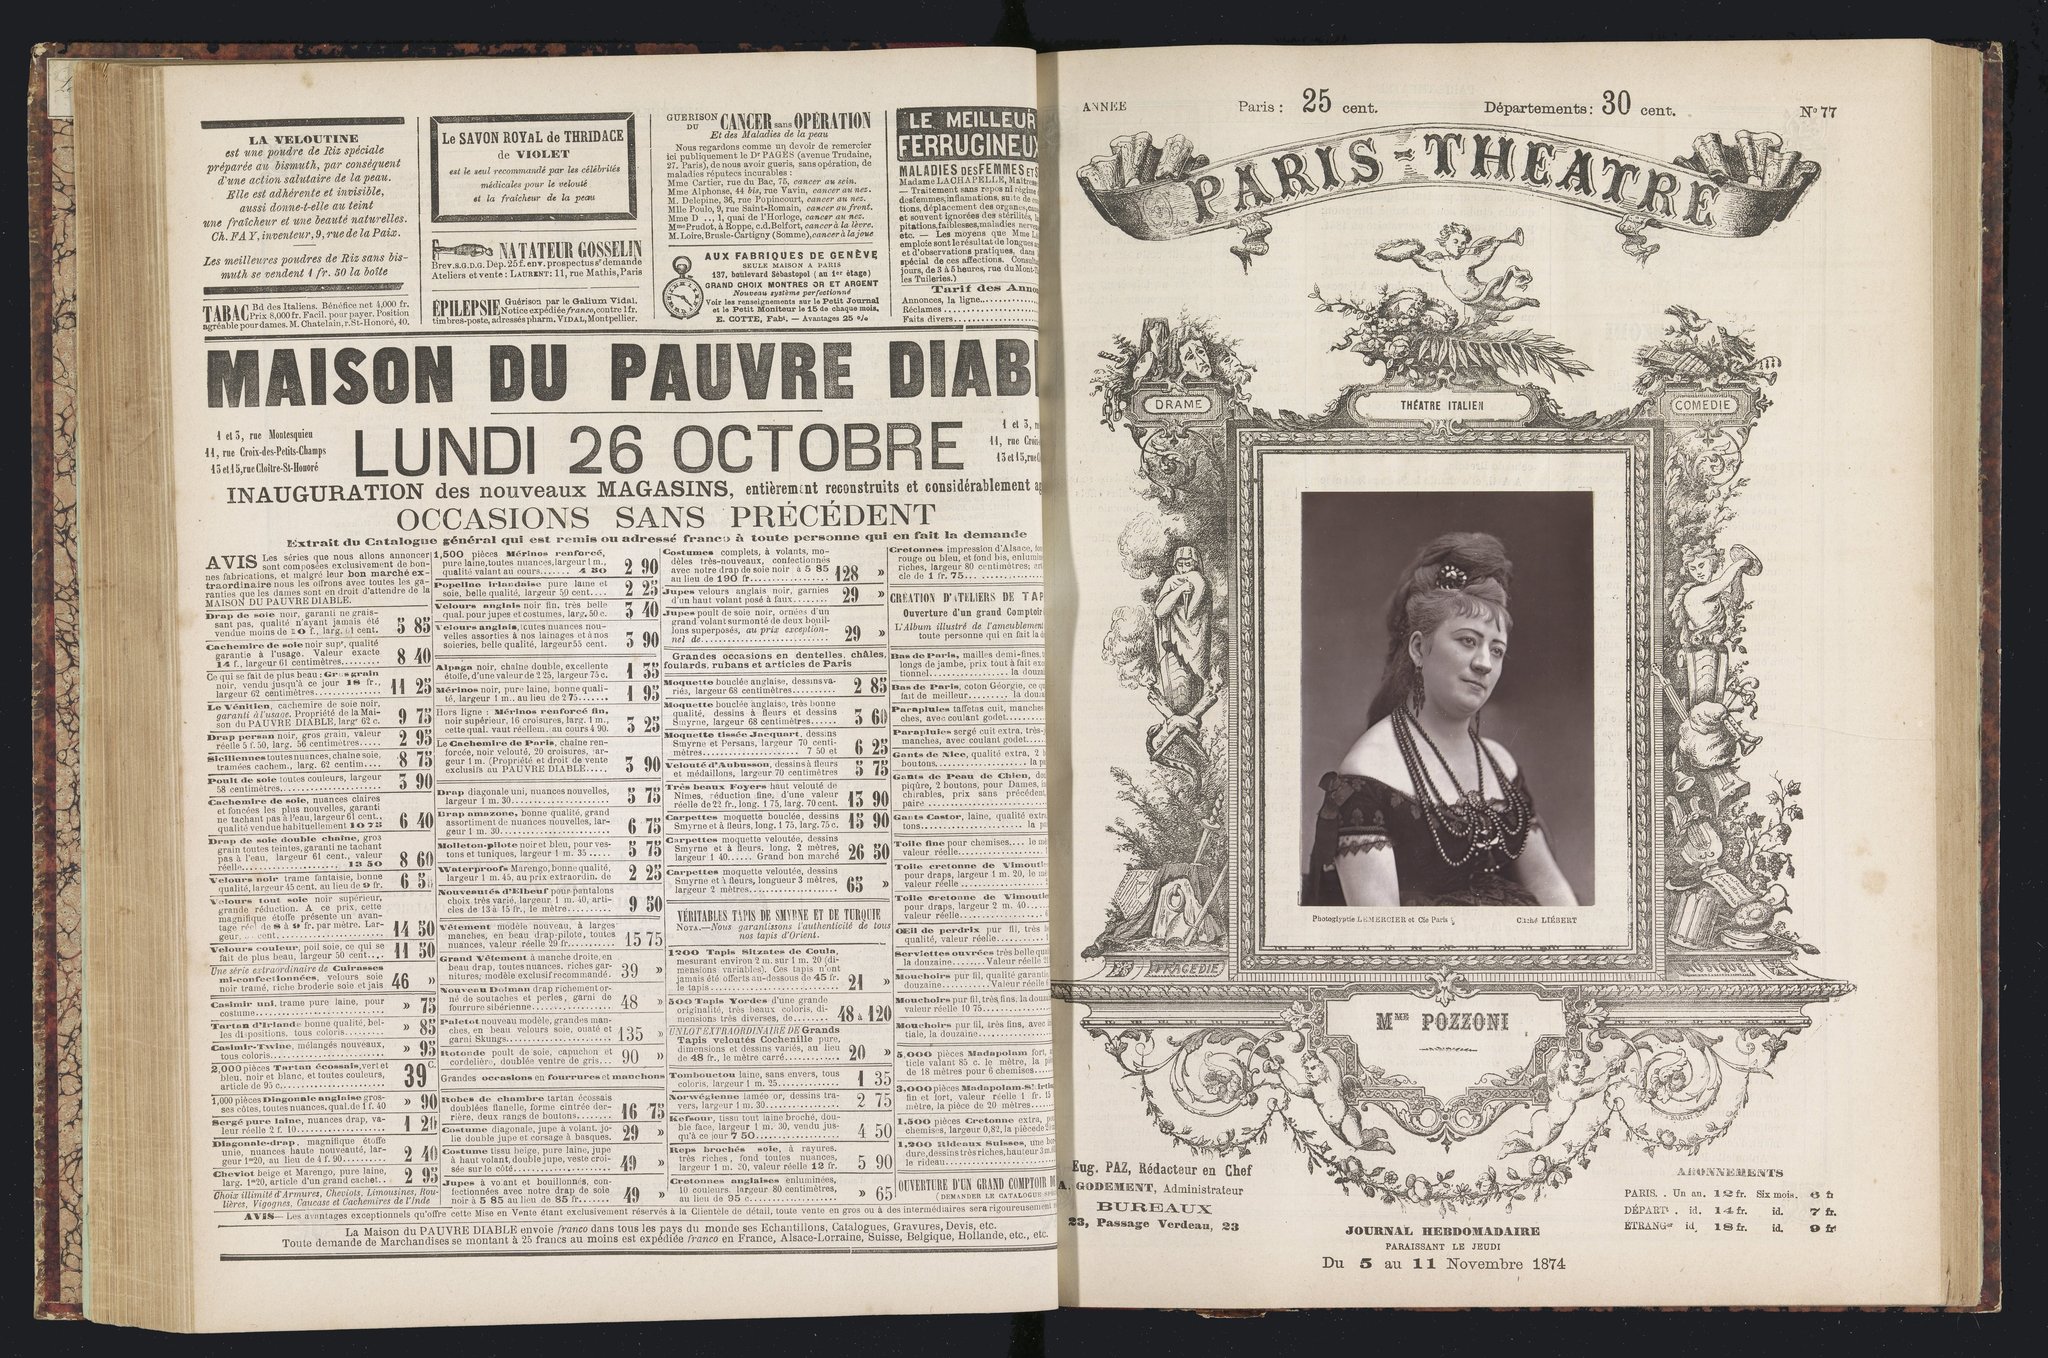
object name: photomechanical print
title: Portret van Antonietta Pozzoni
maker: alphonse-justin liébert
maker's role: fotograaf, marinier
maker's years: 1827-1914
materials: paper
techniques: woodburytype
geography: france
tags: portrait of opera-singer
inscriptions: number: ‘No 77’, inscription: ‘Journal hebdomadaire paraissant le jeudi Du 5 au 11 Novembre 1874’